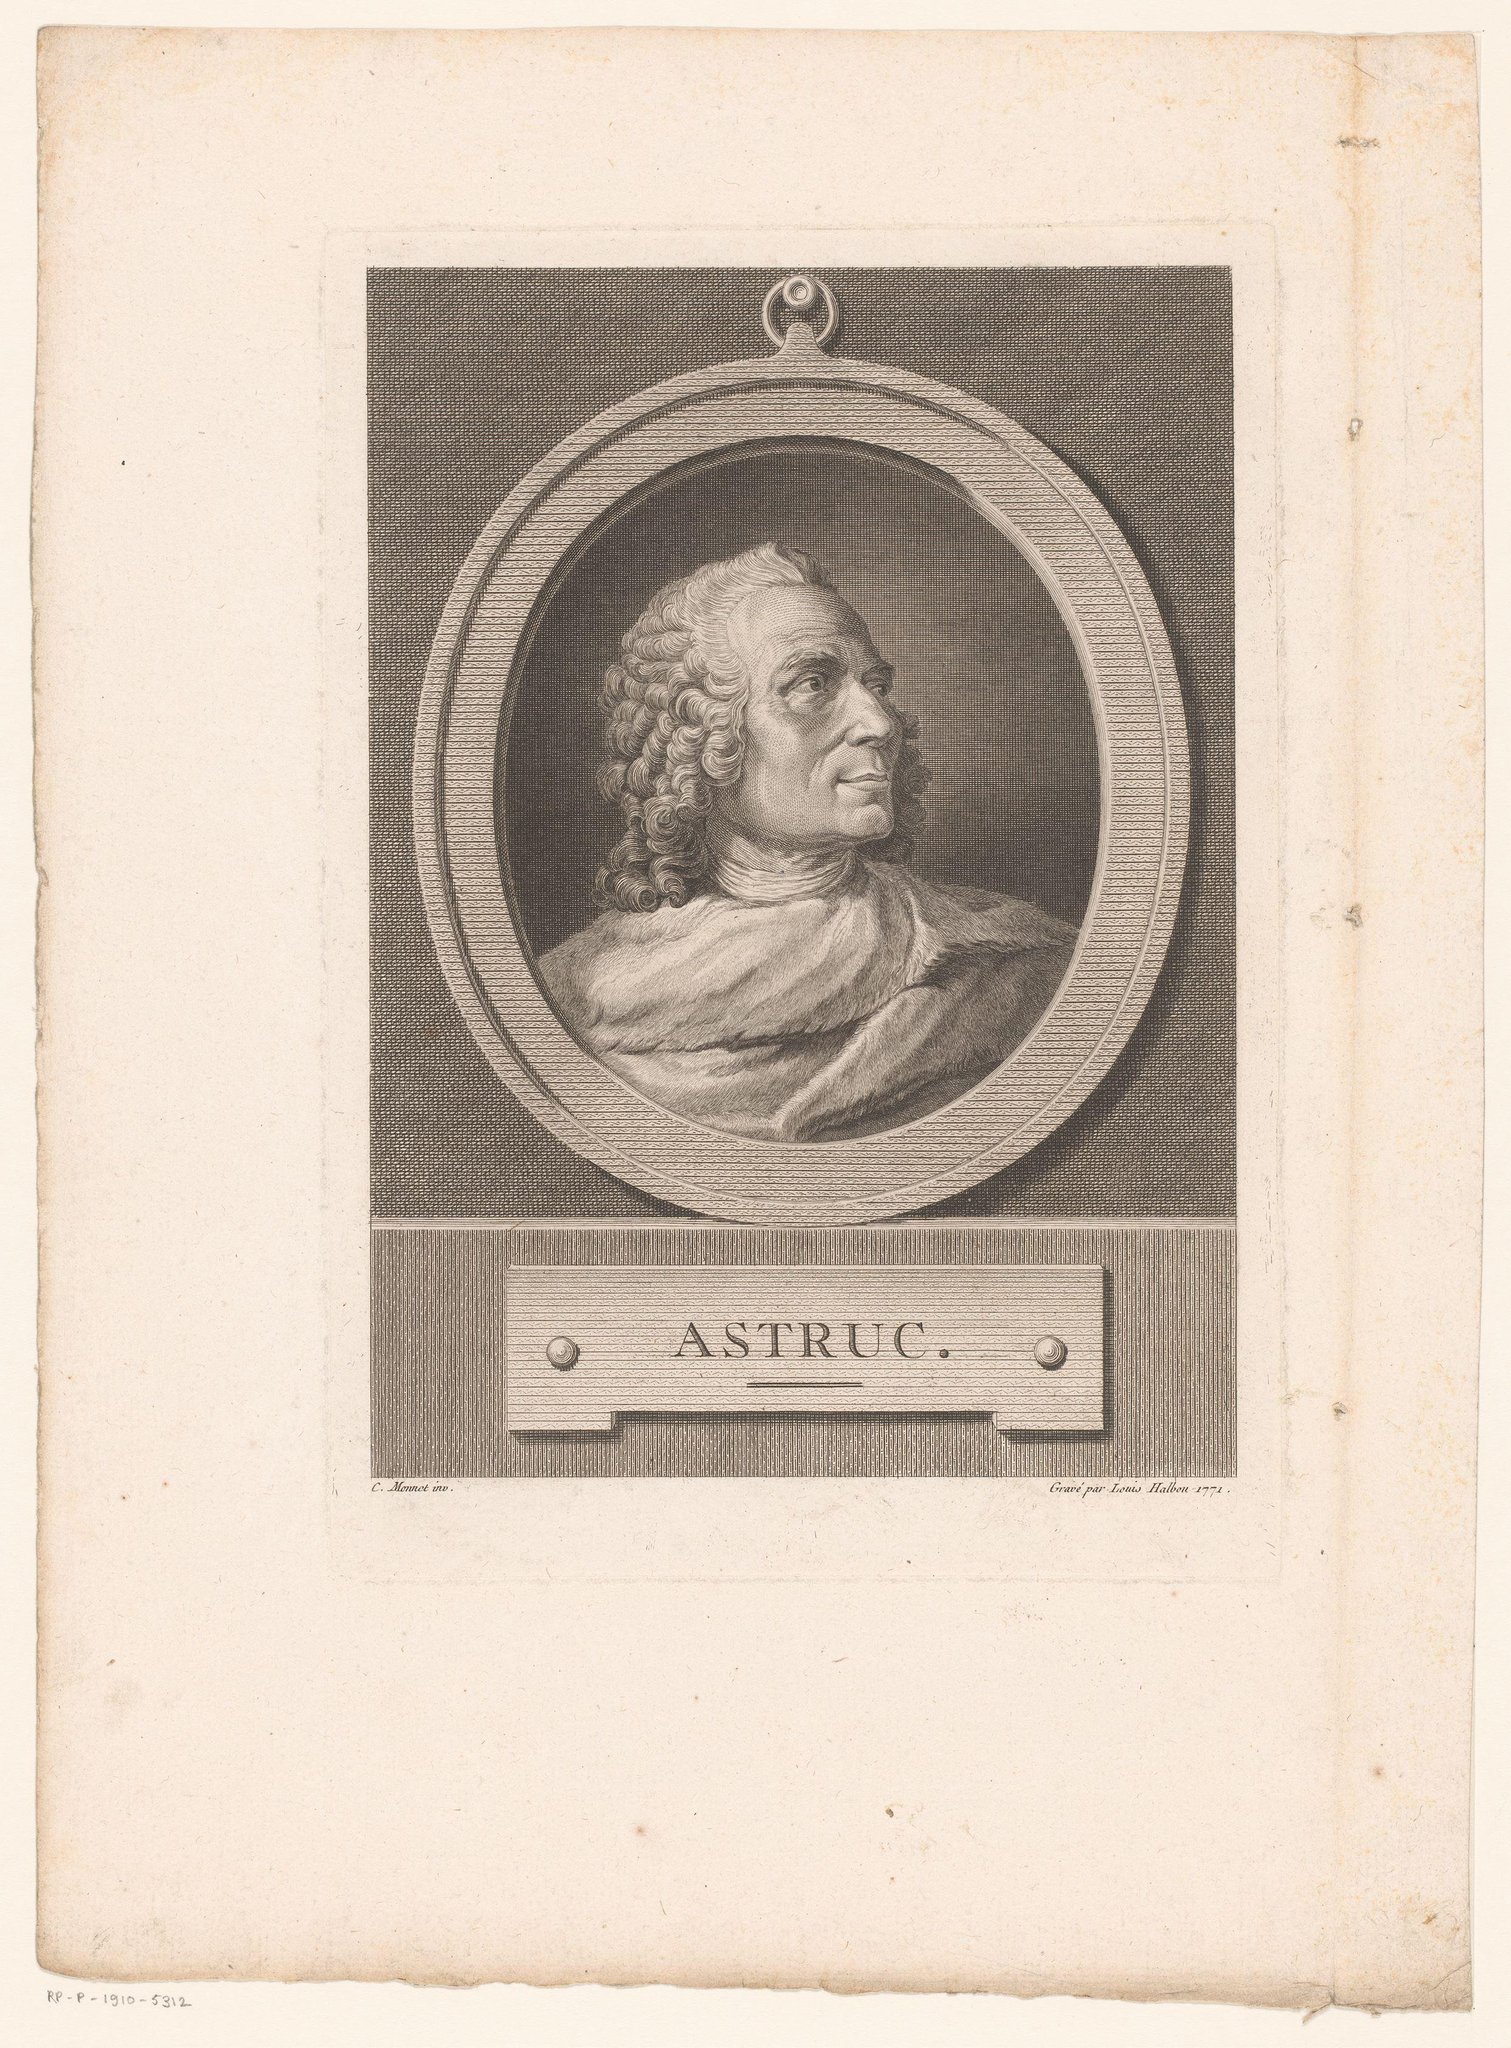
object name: print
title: Portret van Jean Astruc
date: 1771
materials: paper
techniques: engraving, etching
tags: paris, historical persons, physician, doctor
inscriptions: collector's mark: Lugt 2228